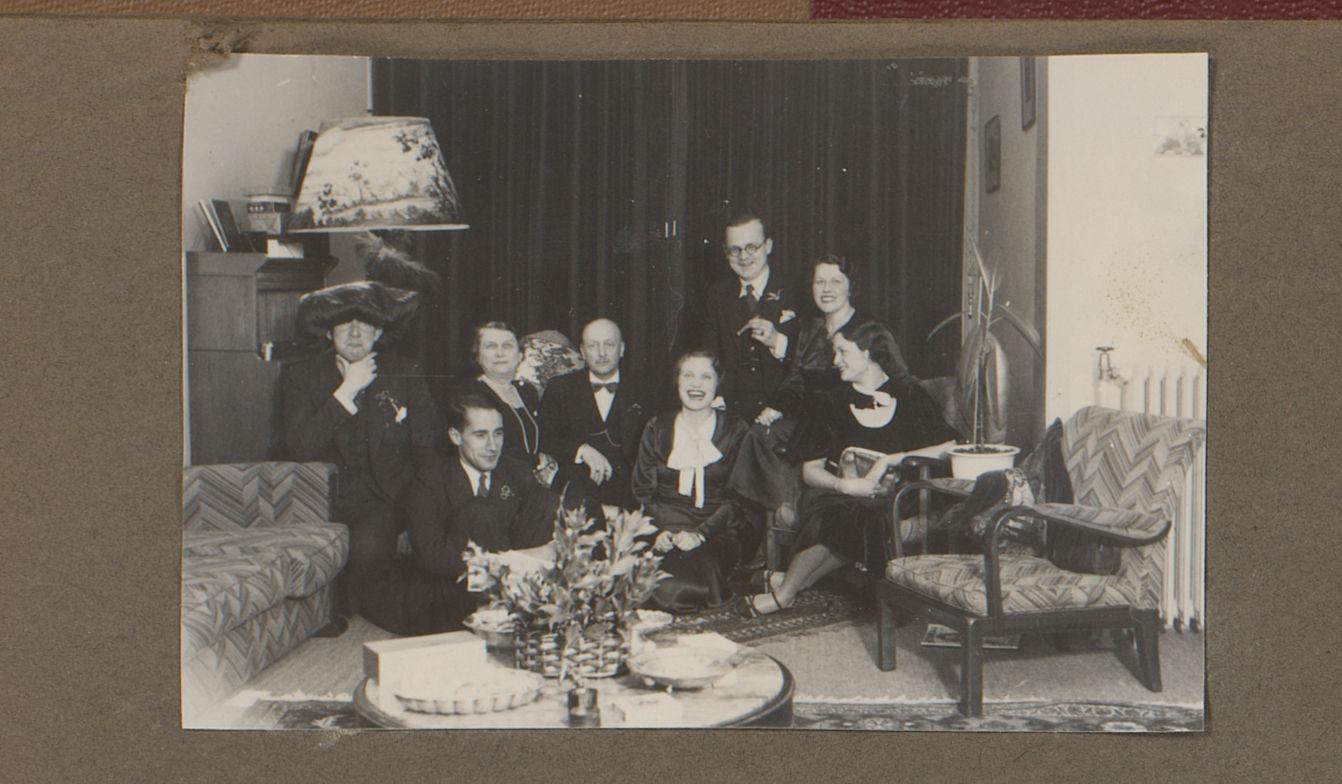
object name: photograph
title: Groepsportret van een gezelschap bij een feest in een woonkamer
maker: Anonymous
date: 1934-1935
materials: paper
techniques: gelatin silver print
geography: netherlands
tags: private festivities, merry company, anonymous historical persons portrayed in a group, in a group-portrait, netherlands